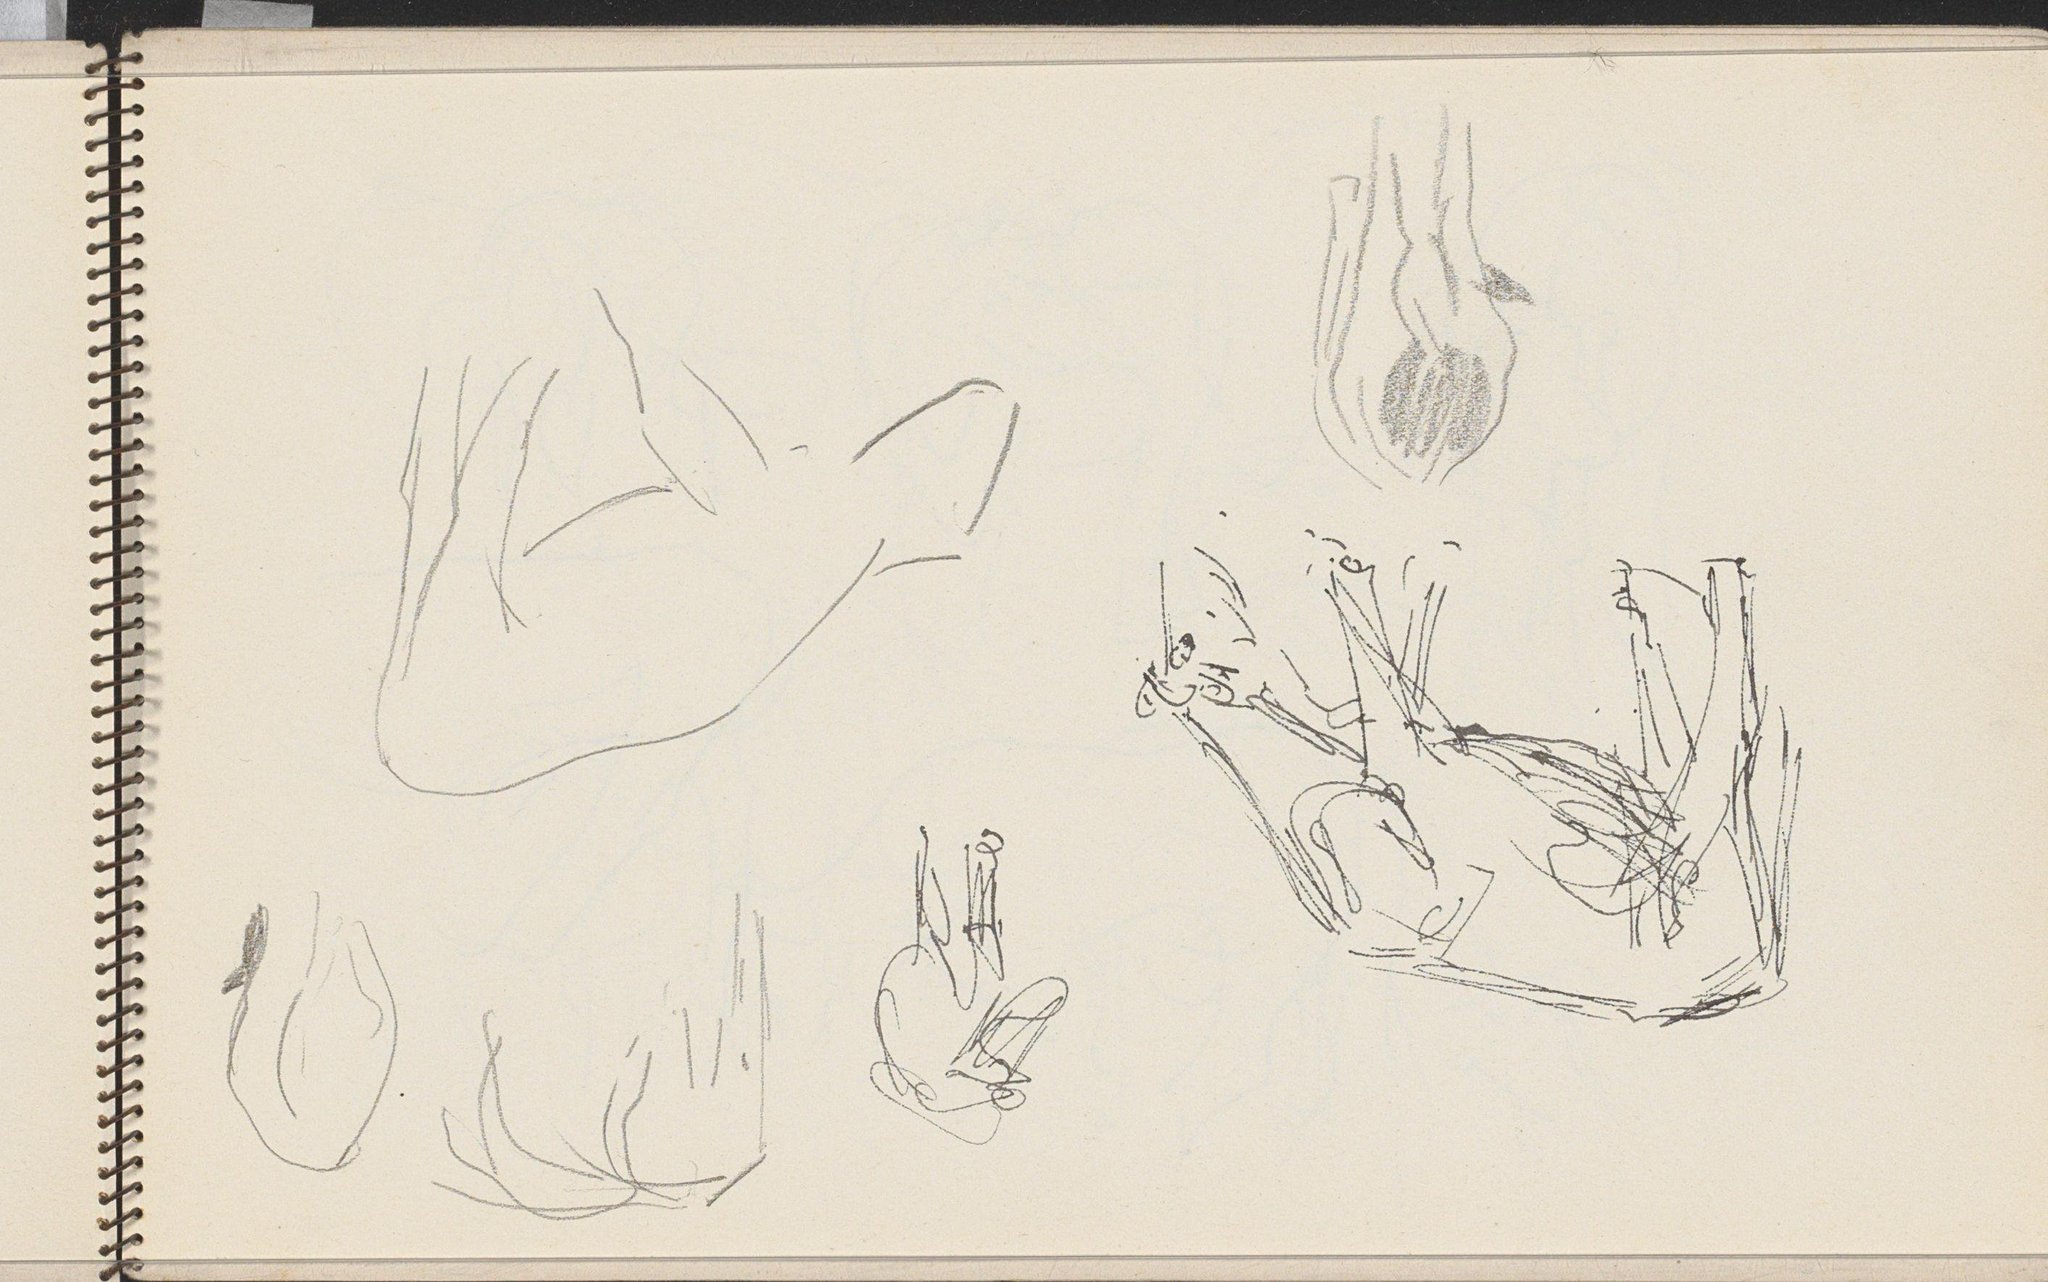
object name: sketchbook leaf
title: Koeien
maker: carel adolph lion cachet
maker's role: draughtsman, print maker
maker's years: 1864-1945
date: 1930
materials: ink, paper, pencil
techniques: pen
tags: cow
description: Blad 15 recto uit een schetsboek met 20 bladen.